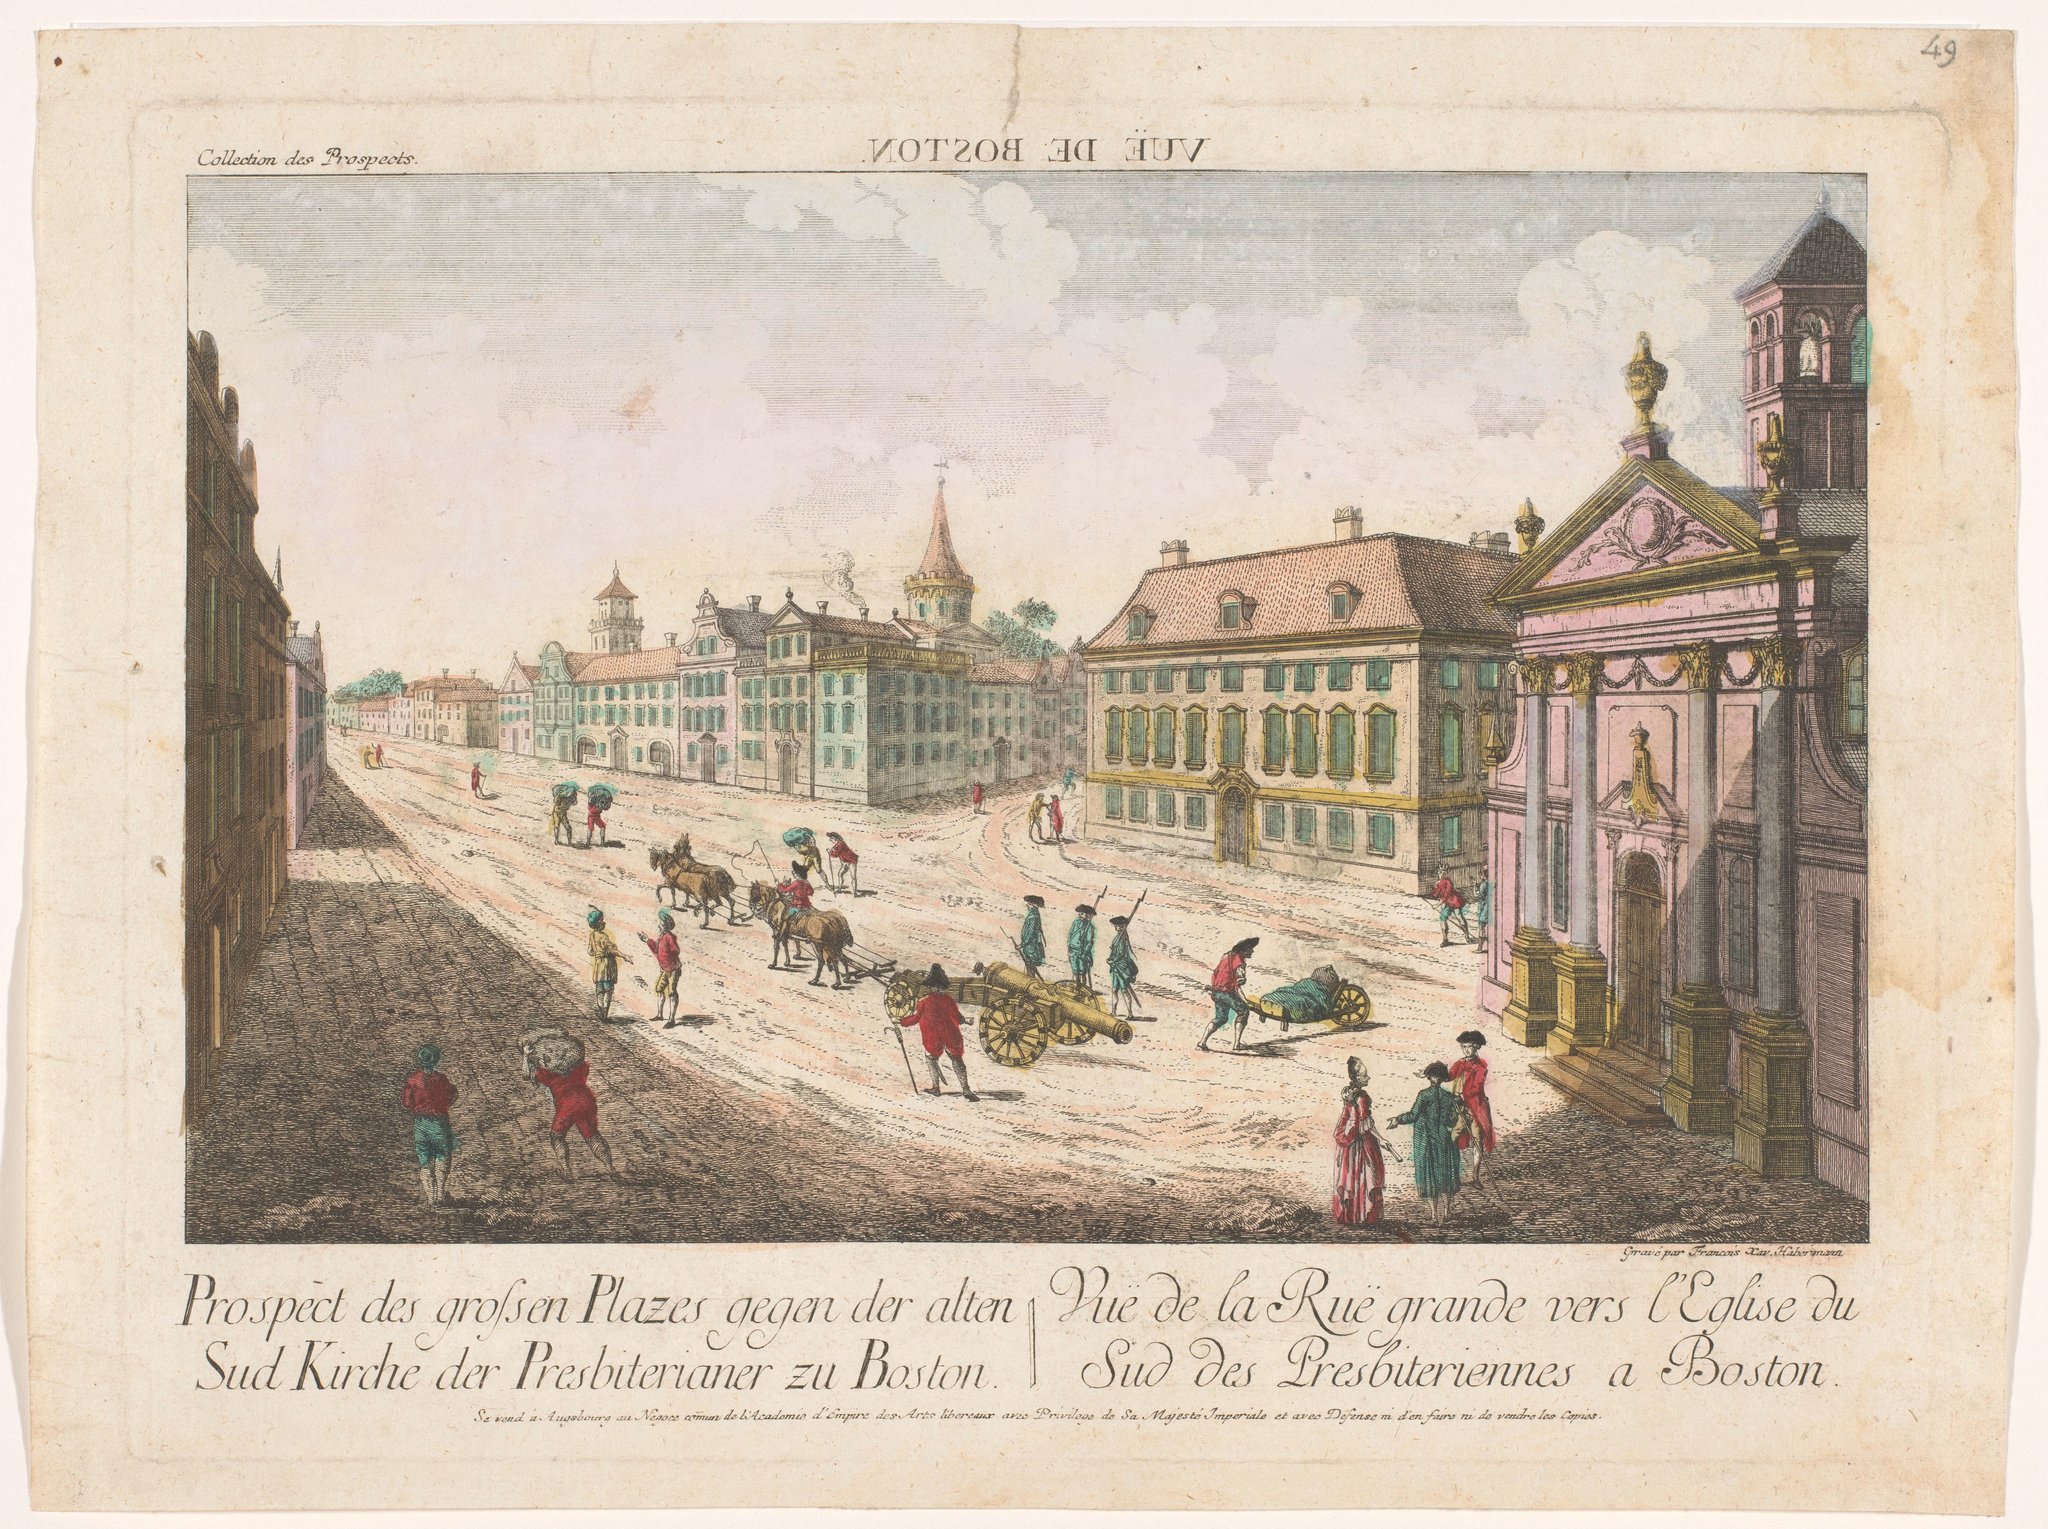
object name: opticaprent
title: Prospect des grossen Plazes gegen der alten Sud Kirche der Presbiterianer zu Boston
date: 1755-1779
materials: paper, watercolor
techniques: brush, etching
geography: augsburg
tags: church (exterior), street (+ city(-scape) with figures, staffage)